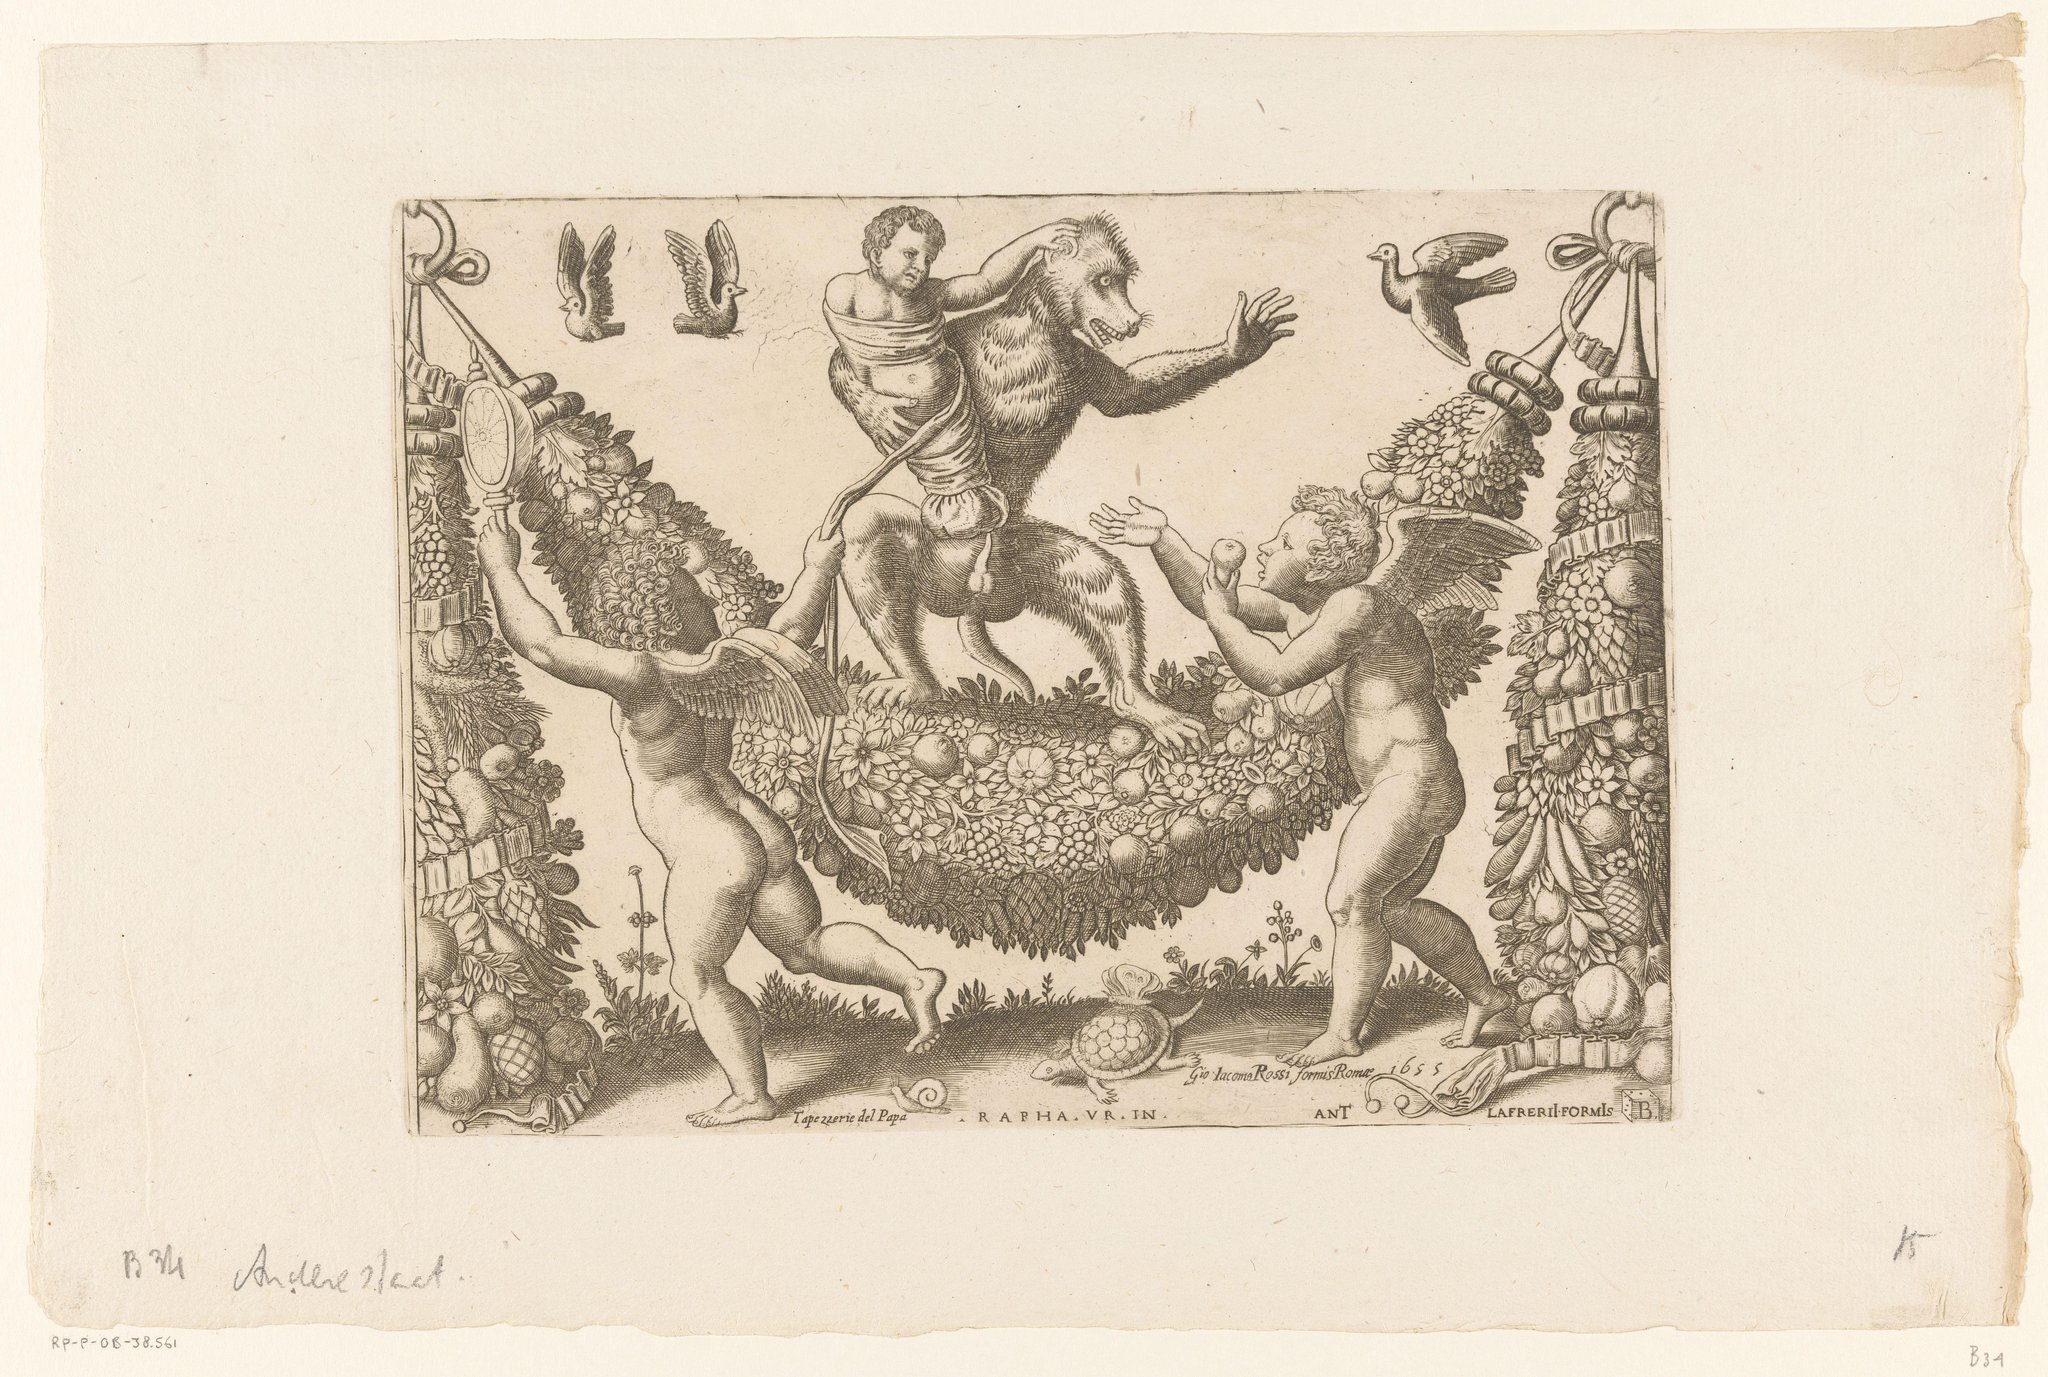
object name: print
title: Putti een aap bespottend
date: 1655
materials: paper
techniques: engraving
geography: italy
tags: tortoises, turtles, monkeys, apes, rattle ~ acoustic signalling, insects: butterfly, molluscs: snail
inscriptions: collector's mark: Lugt 2228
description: Op een grote guirlande staat een aap met een in stof gewikkelde putto. Rechts een putto met een vrucht in de hand en links een putto met een rammelaar. Op de grond een slak, een schildpad en een vlinder.